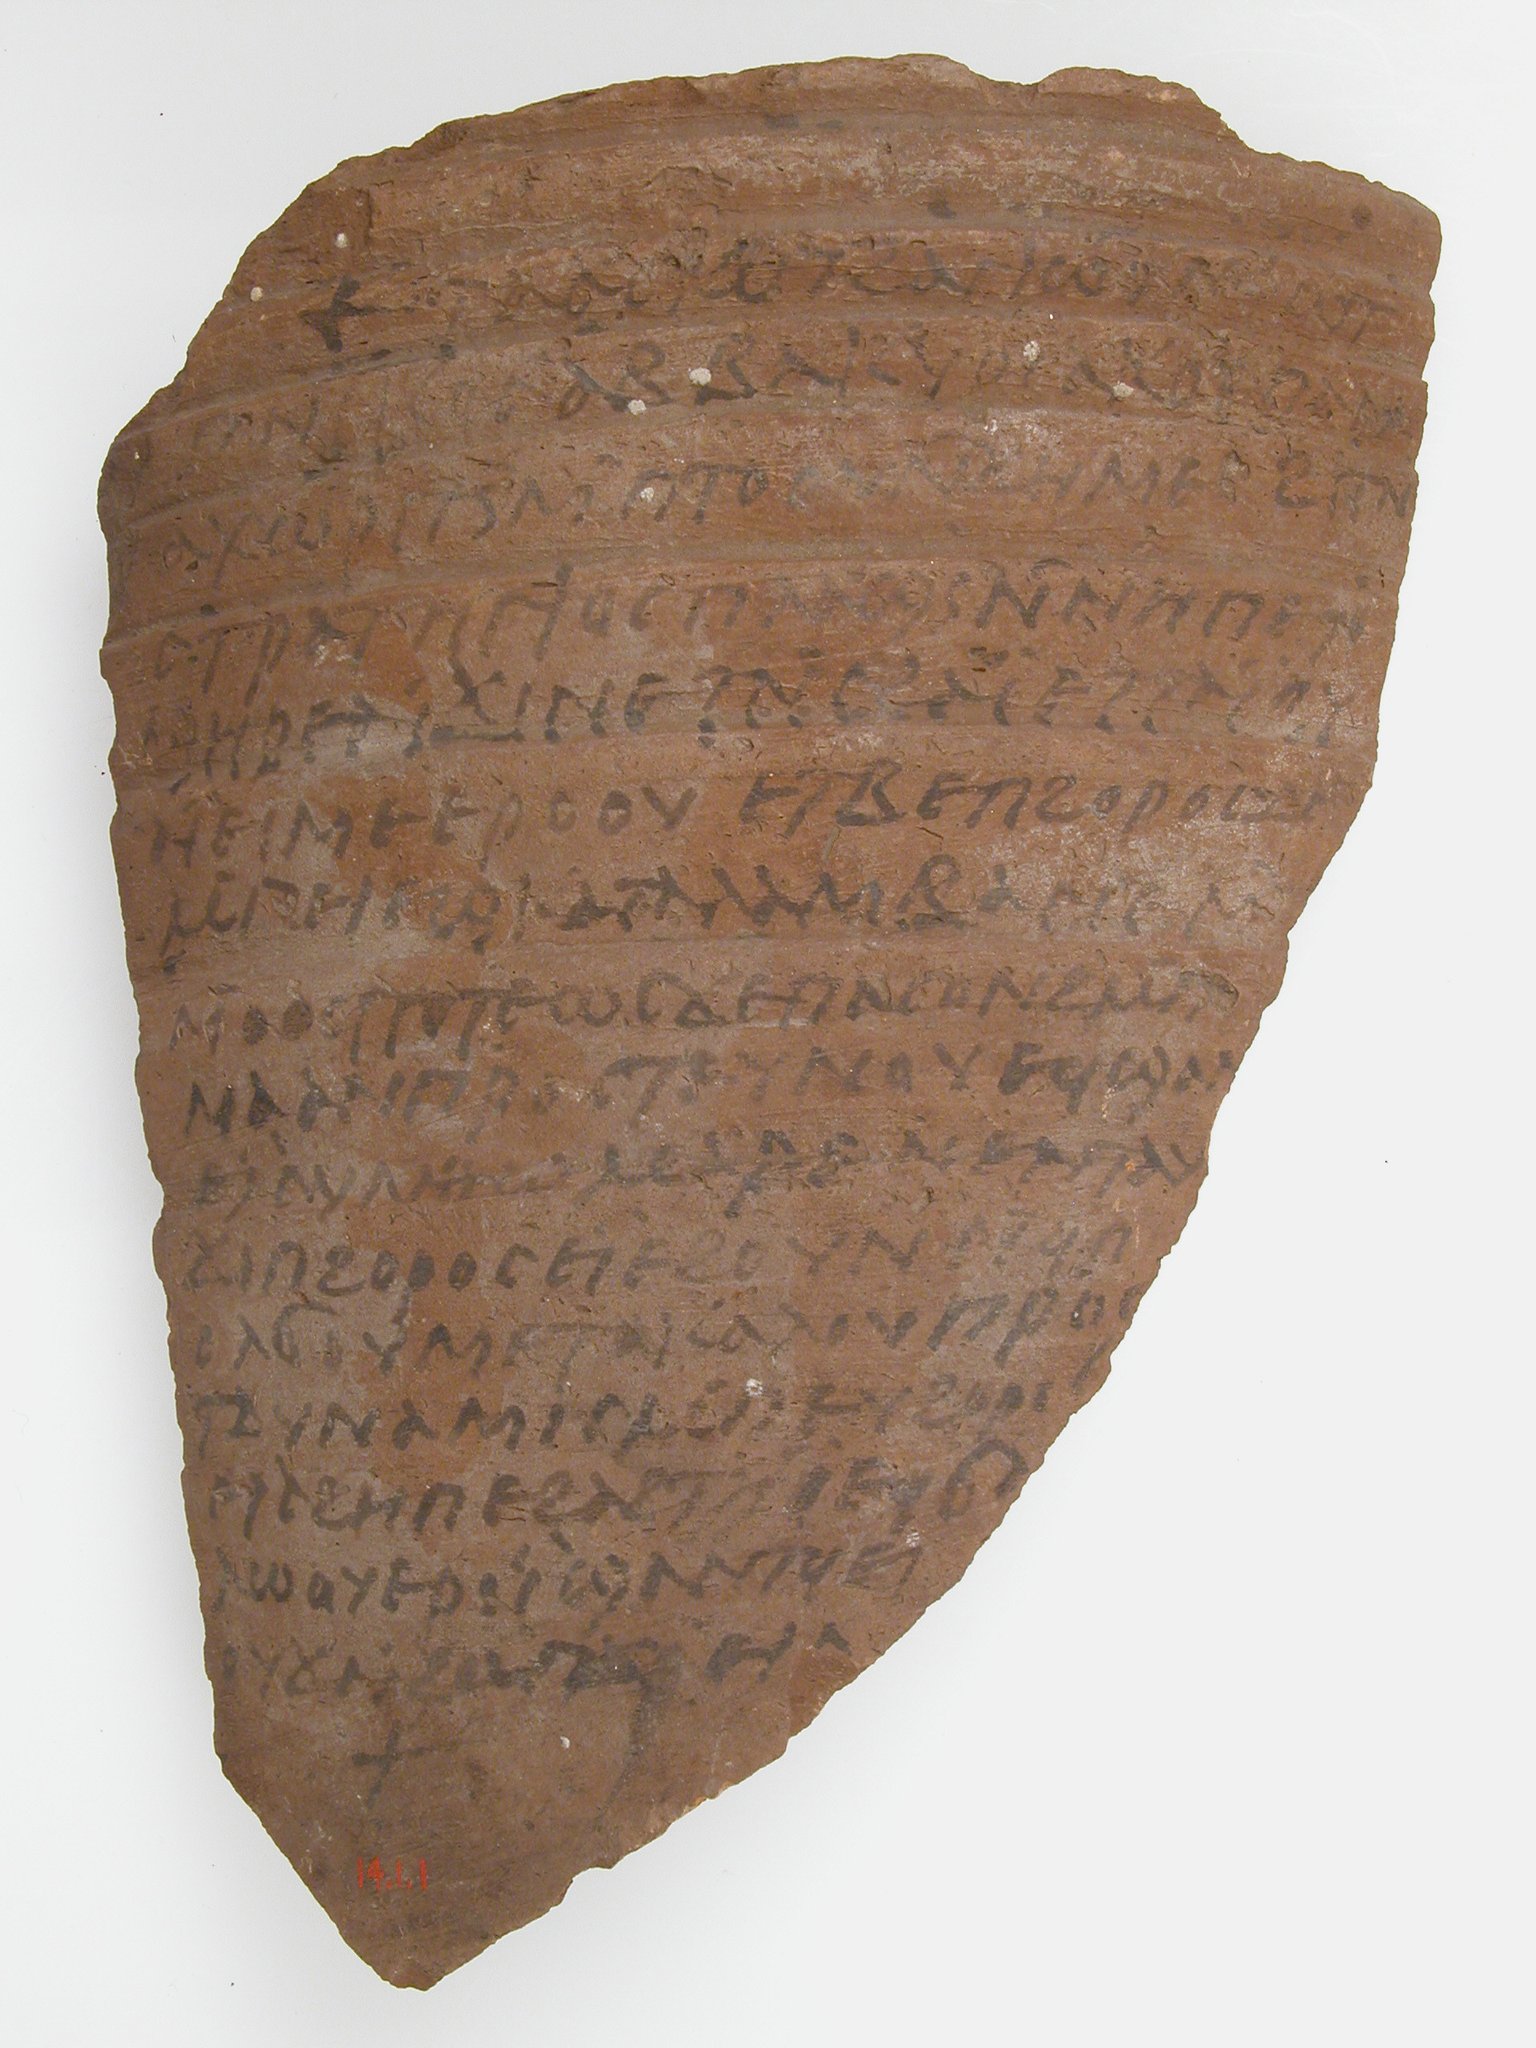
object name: ostrakon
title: Ostrakon with a Letter from Strategius to Cyriacus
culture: coptic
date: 600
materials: ink, pottery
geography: egypt